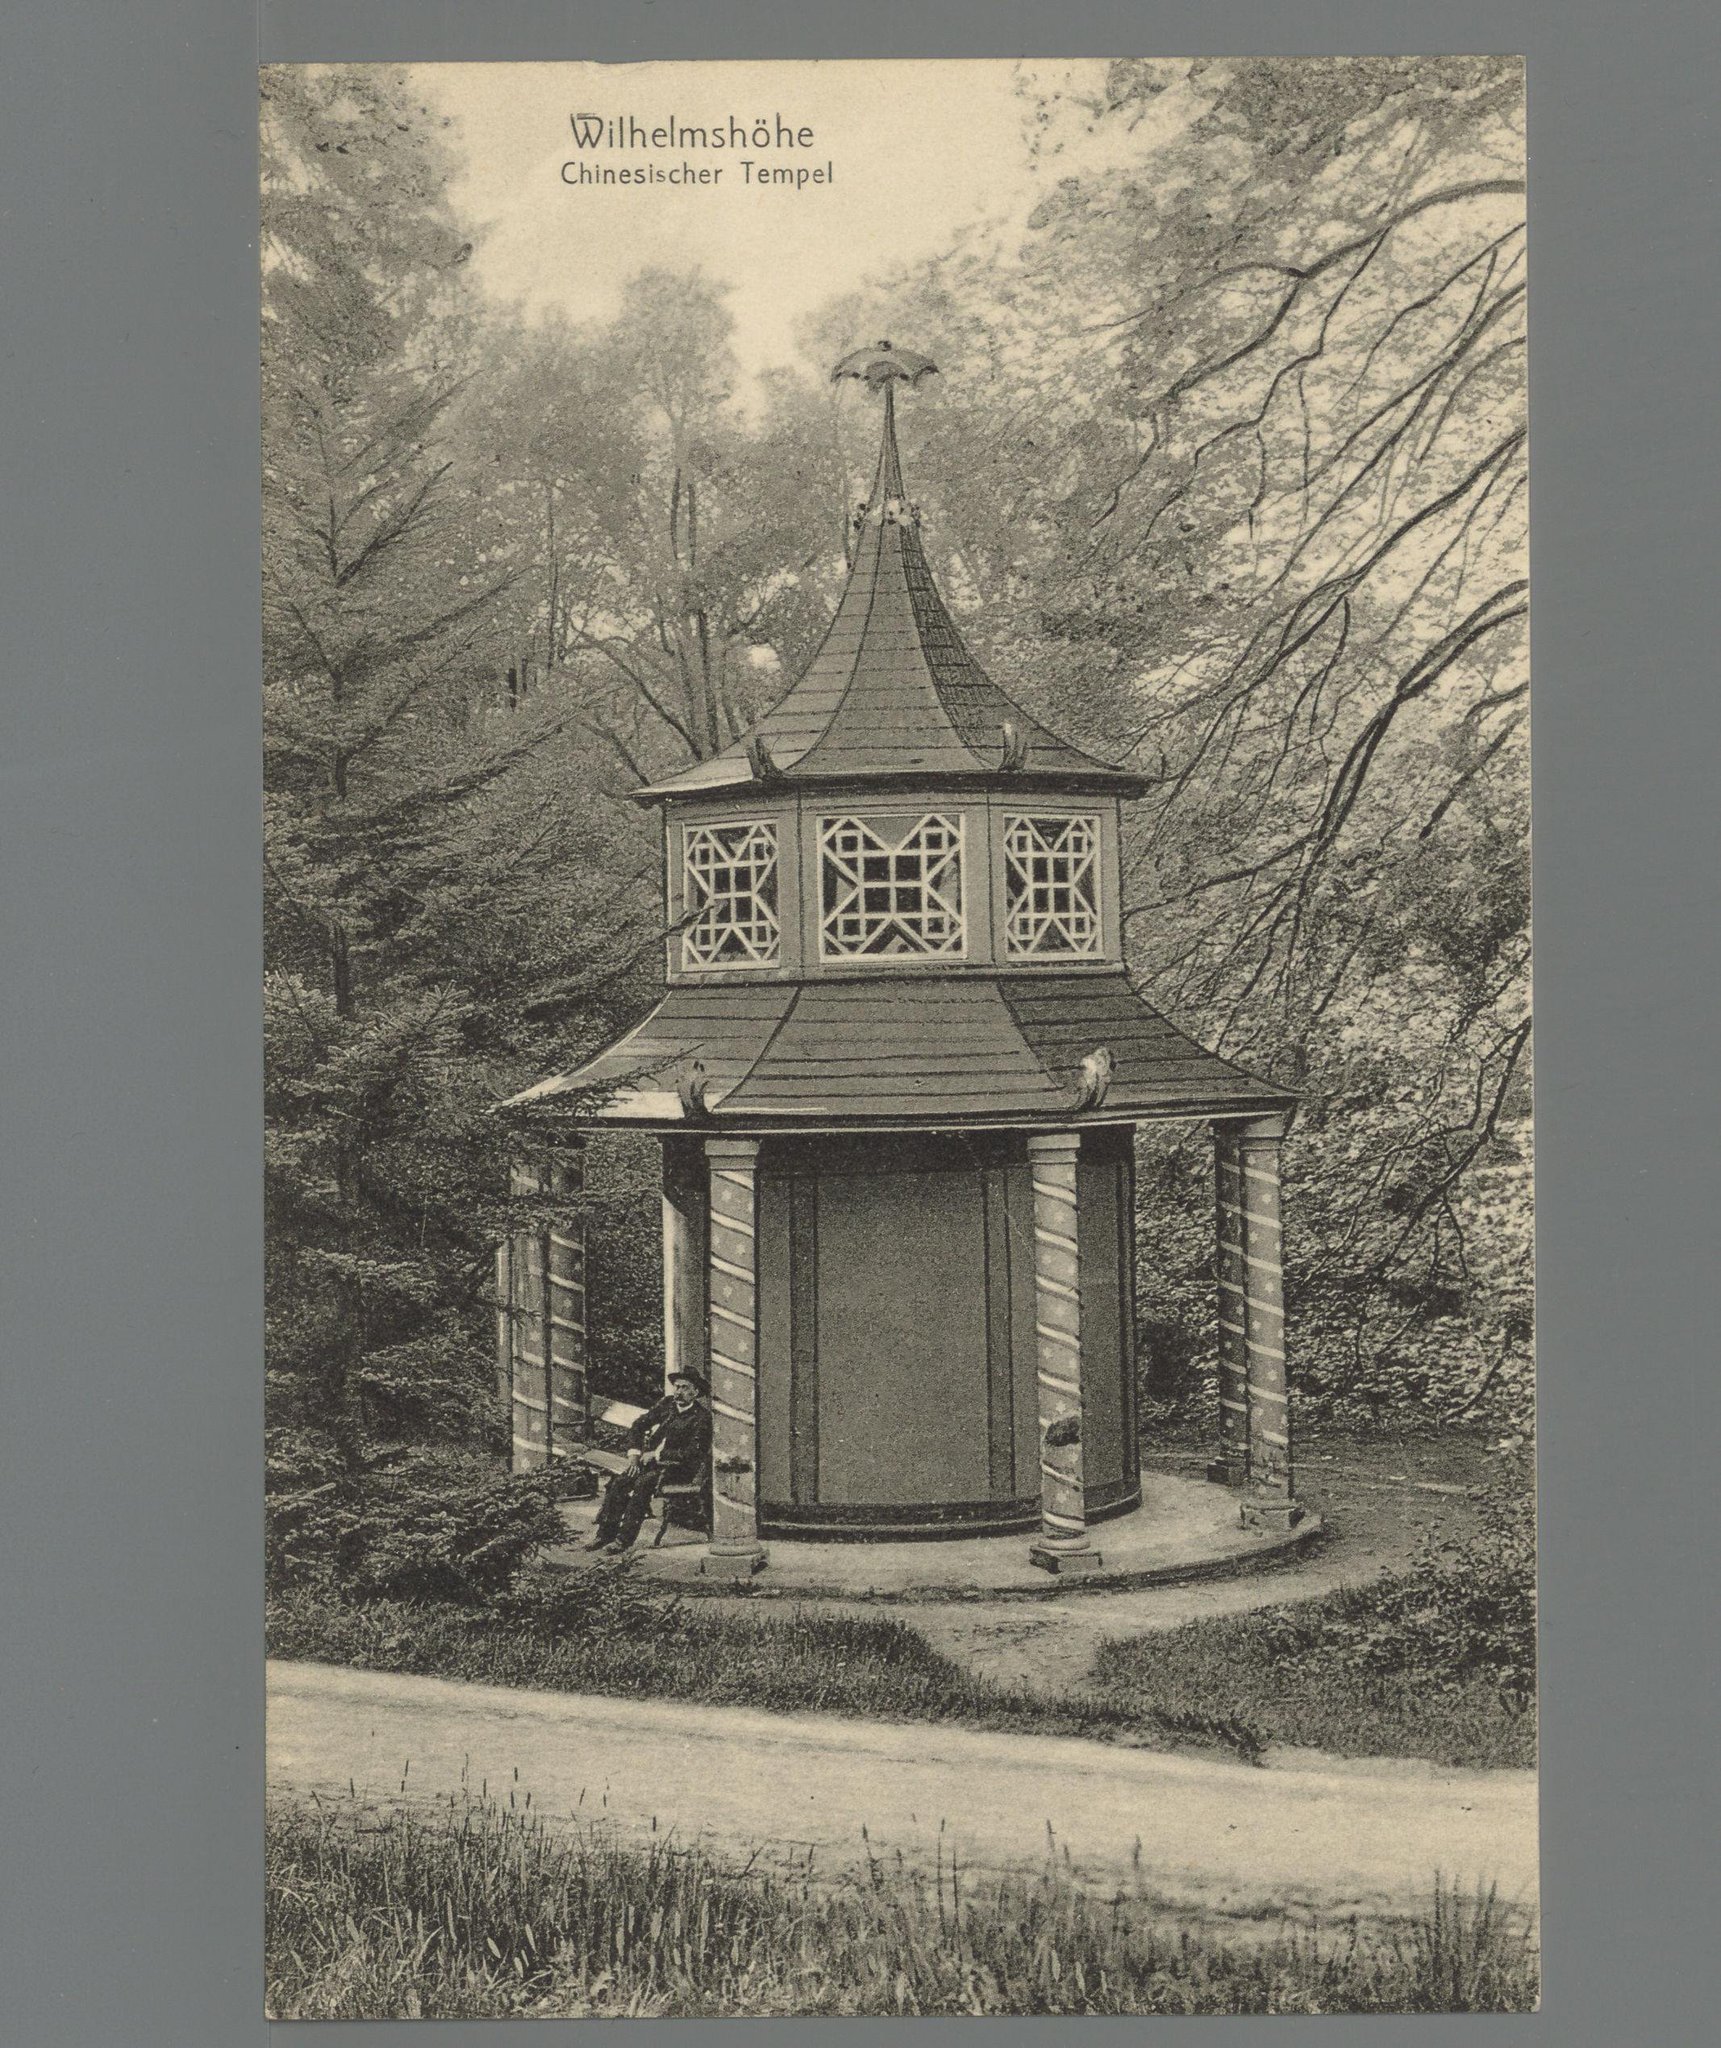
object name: photomechanical print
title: Wilhelmshöhe. Chinesischer Tempel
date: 1905-1930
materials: cardboard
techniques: photograph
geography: kassel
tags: park, temple, shrine ~ shinto